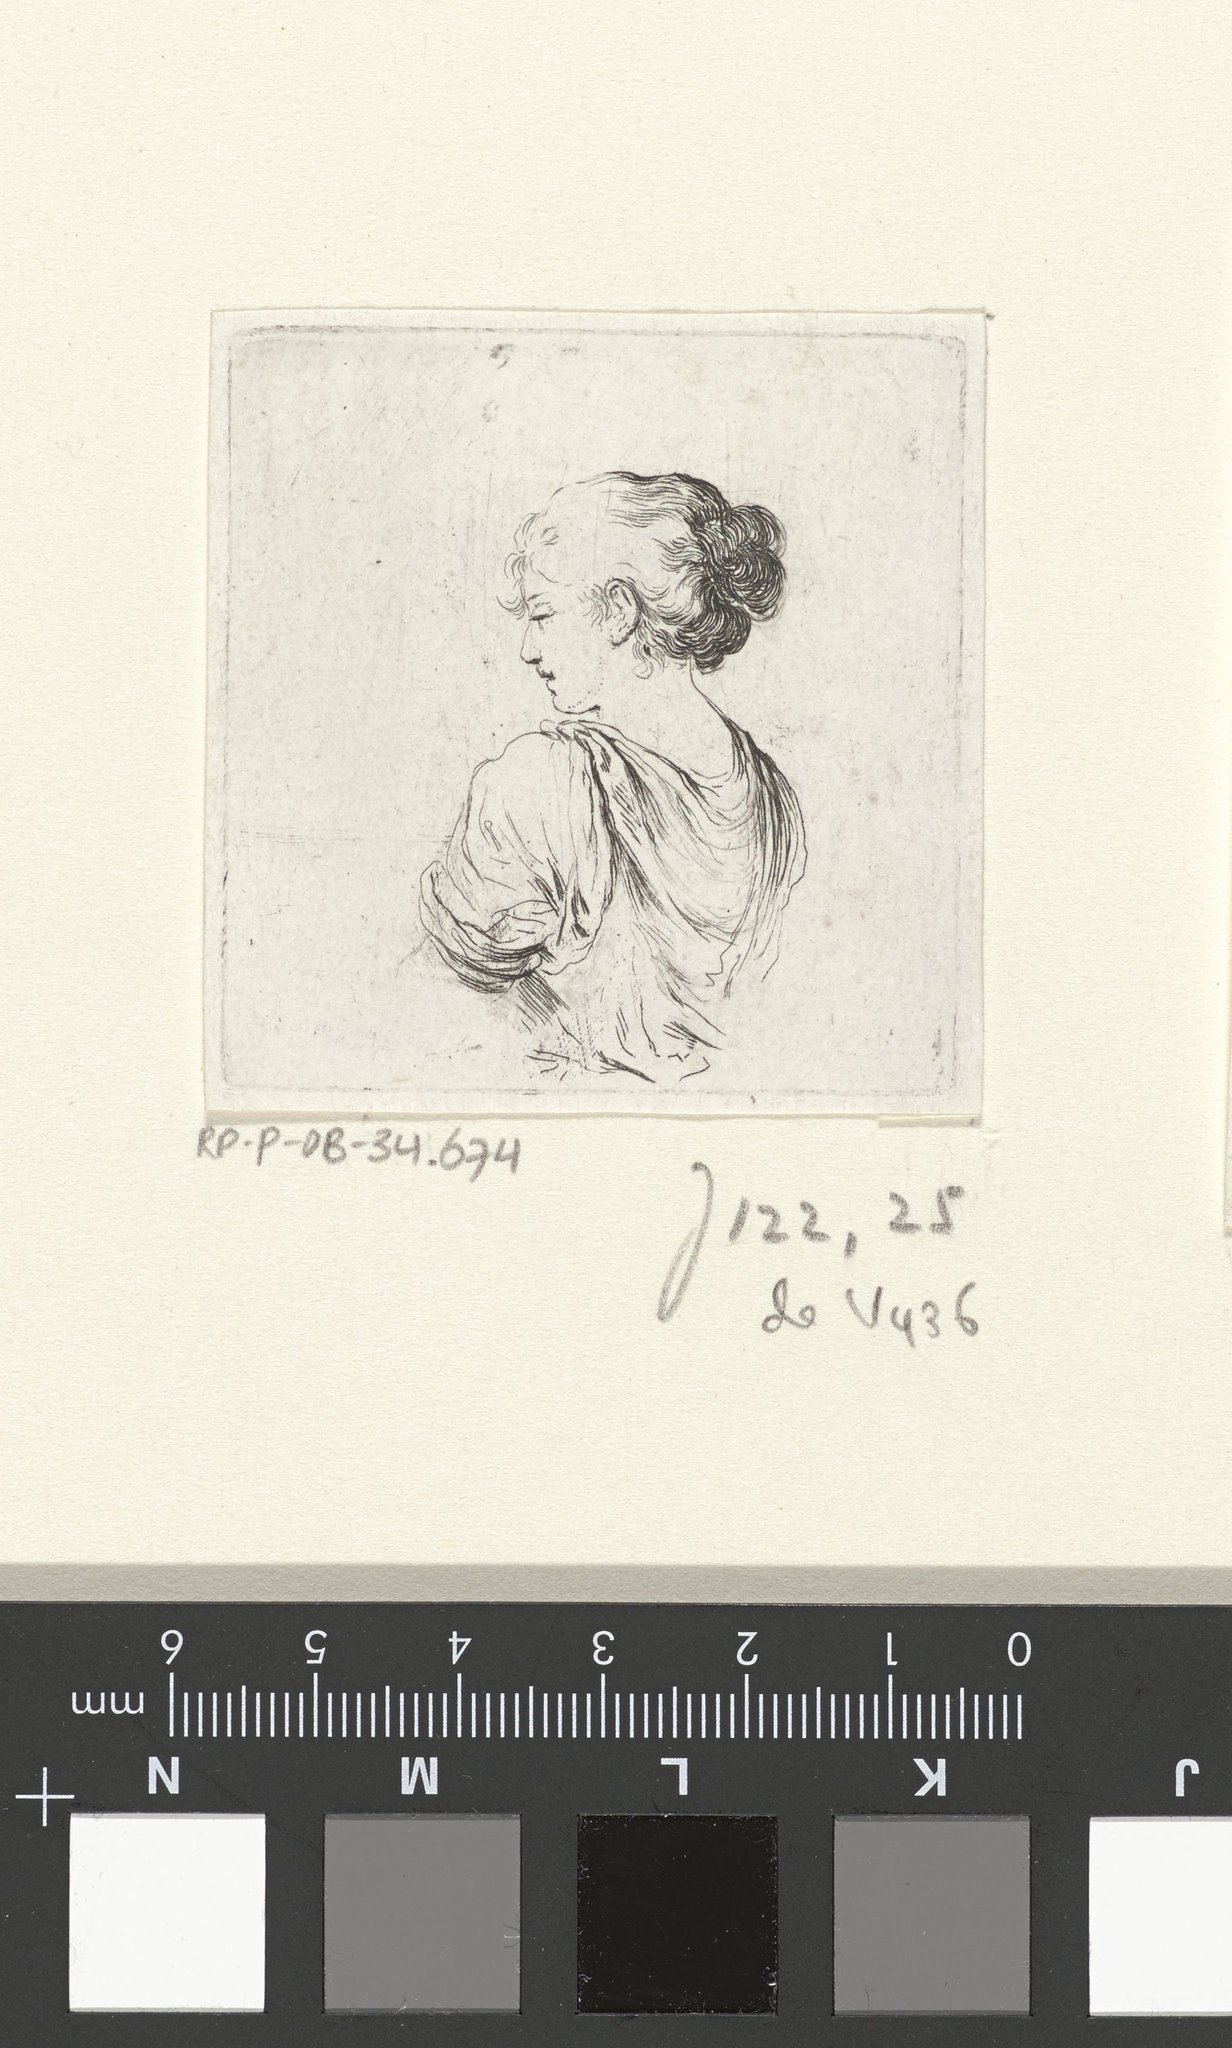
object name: print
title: Vrouw met opgestoken haar op de rug gezien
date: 1620-1664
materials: paper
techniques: etching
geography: paris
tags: adult woman (+ back view)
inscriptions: collector's mark: Lugt 240